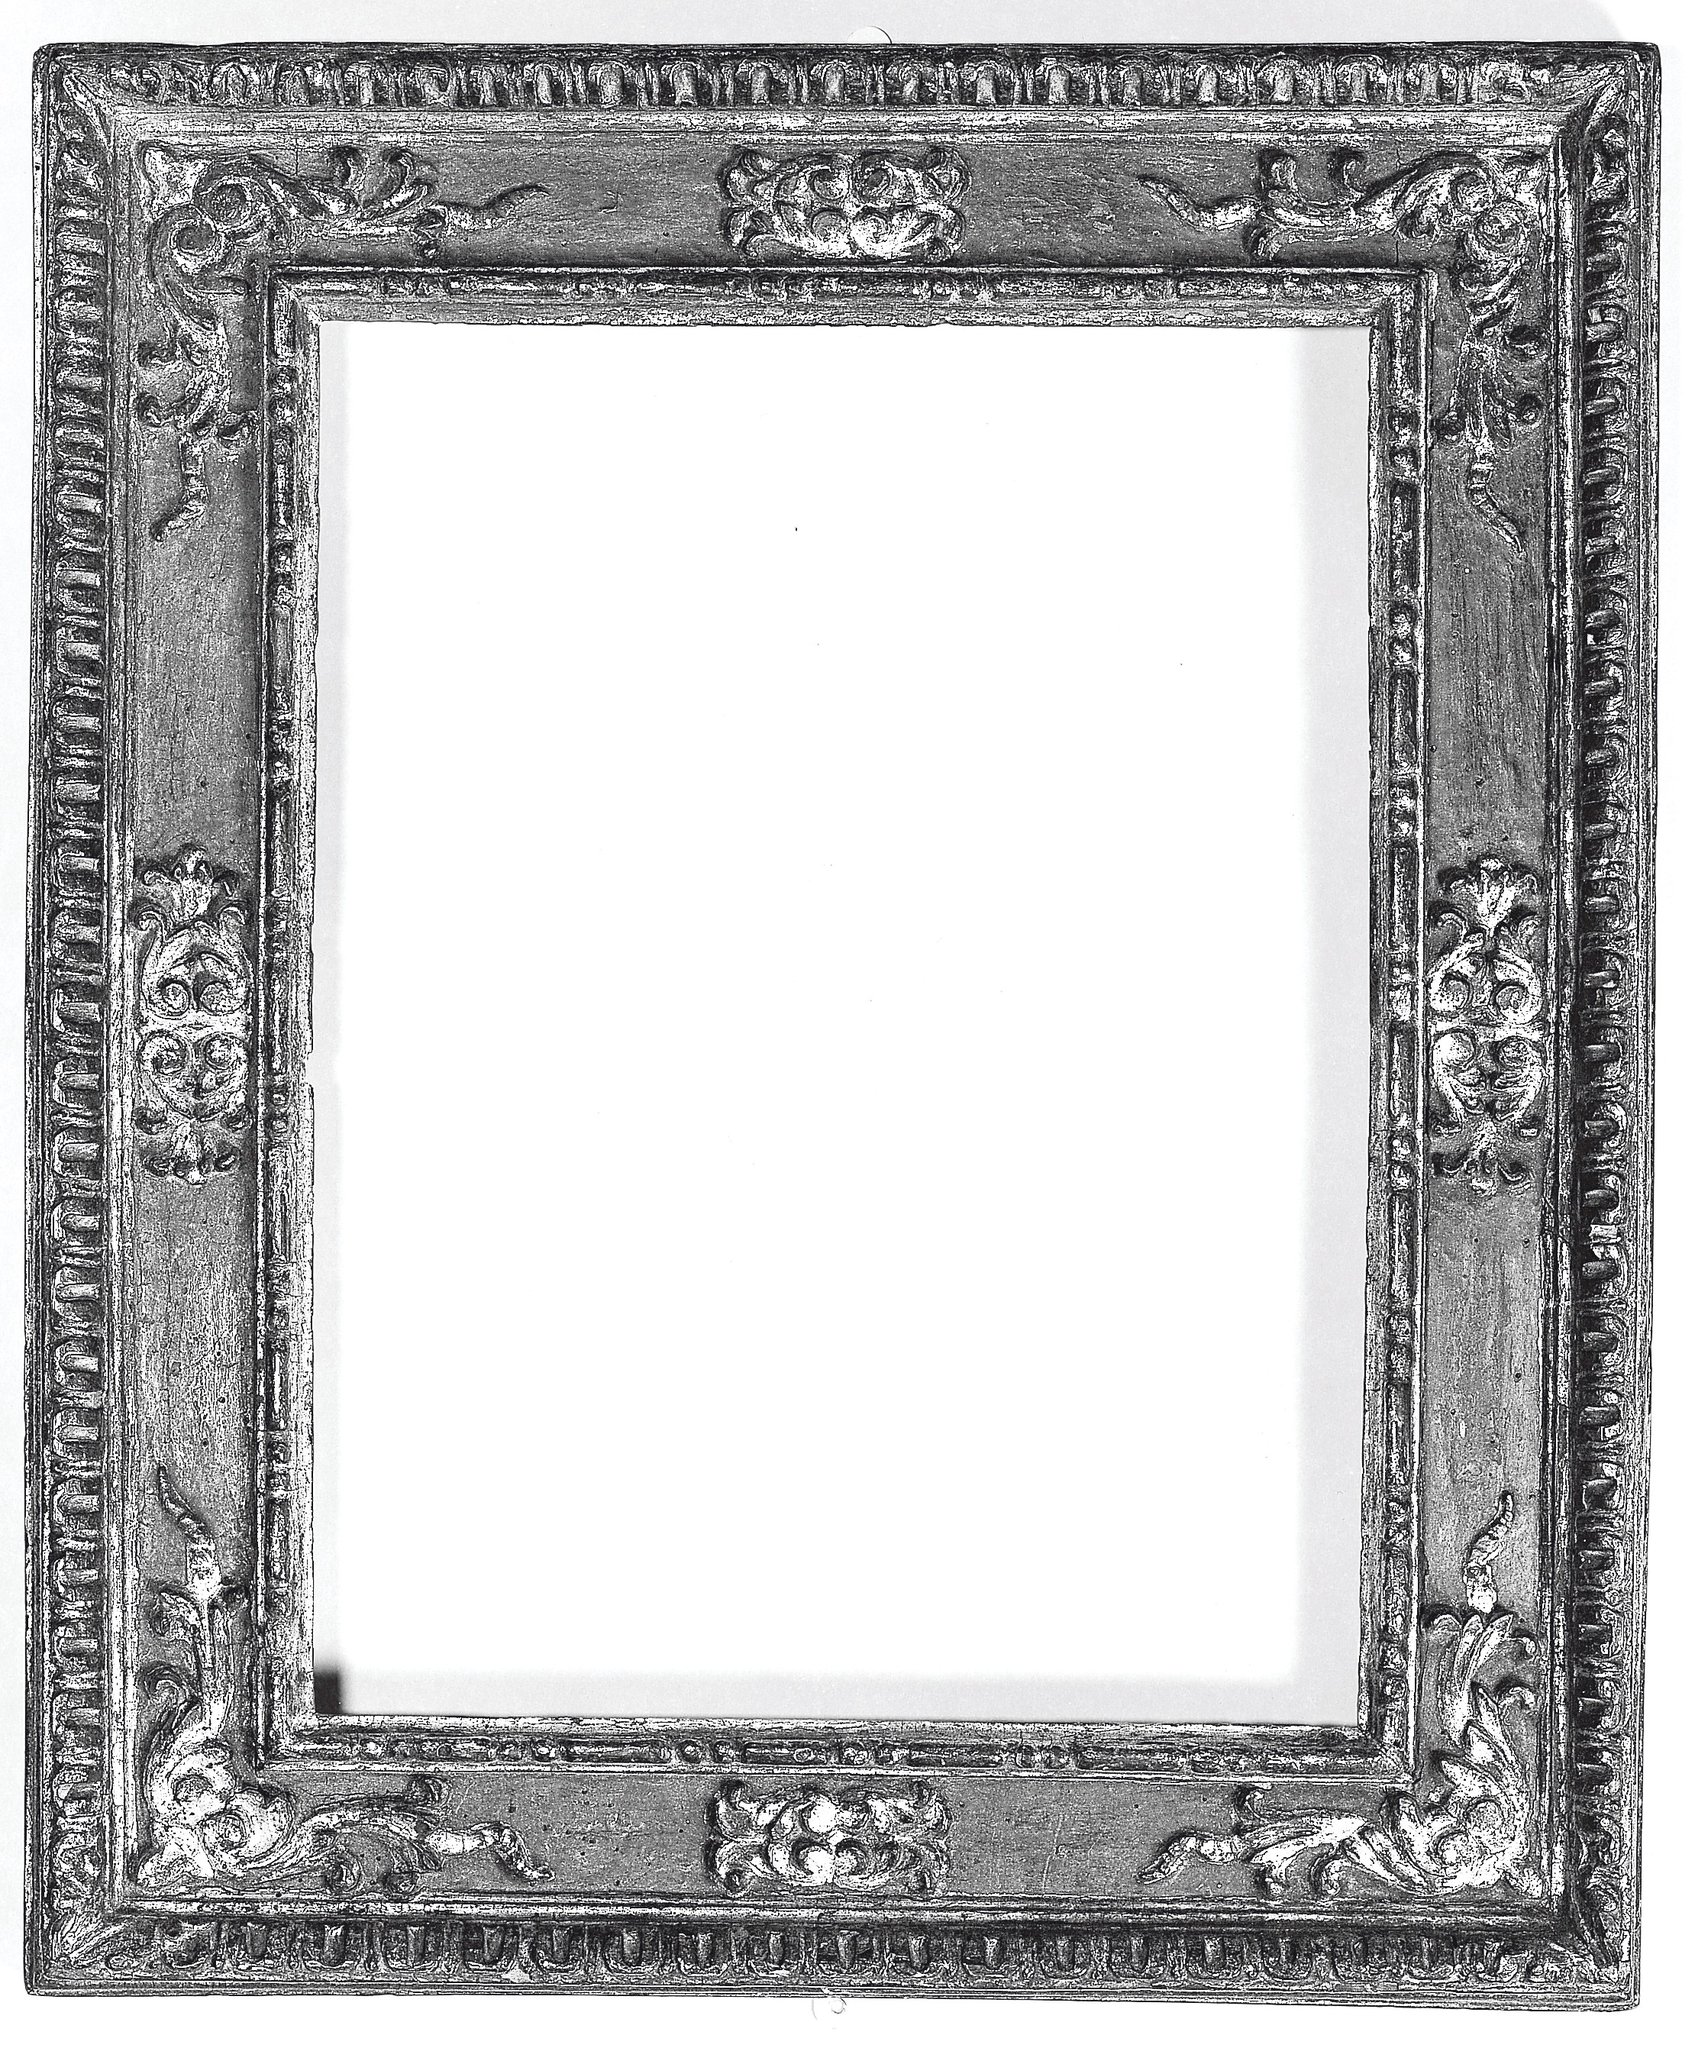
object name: frame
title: Cassetta frame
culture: italian, tuscany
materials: wood